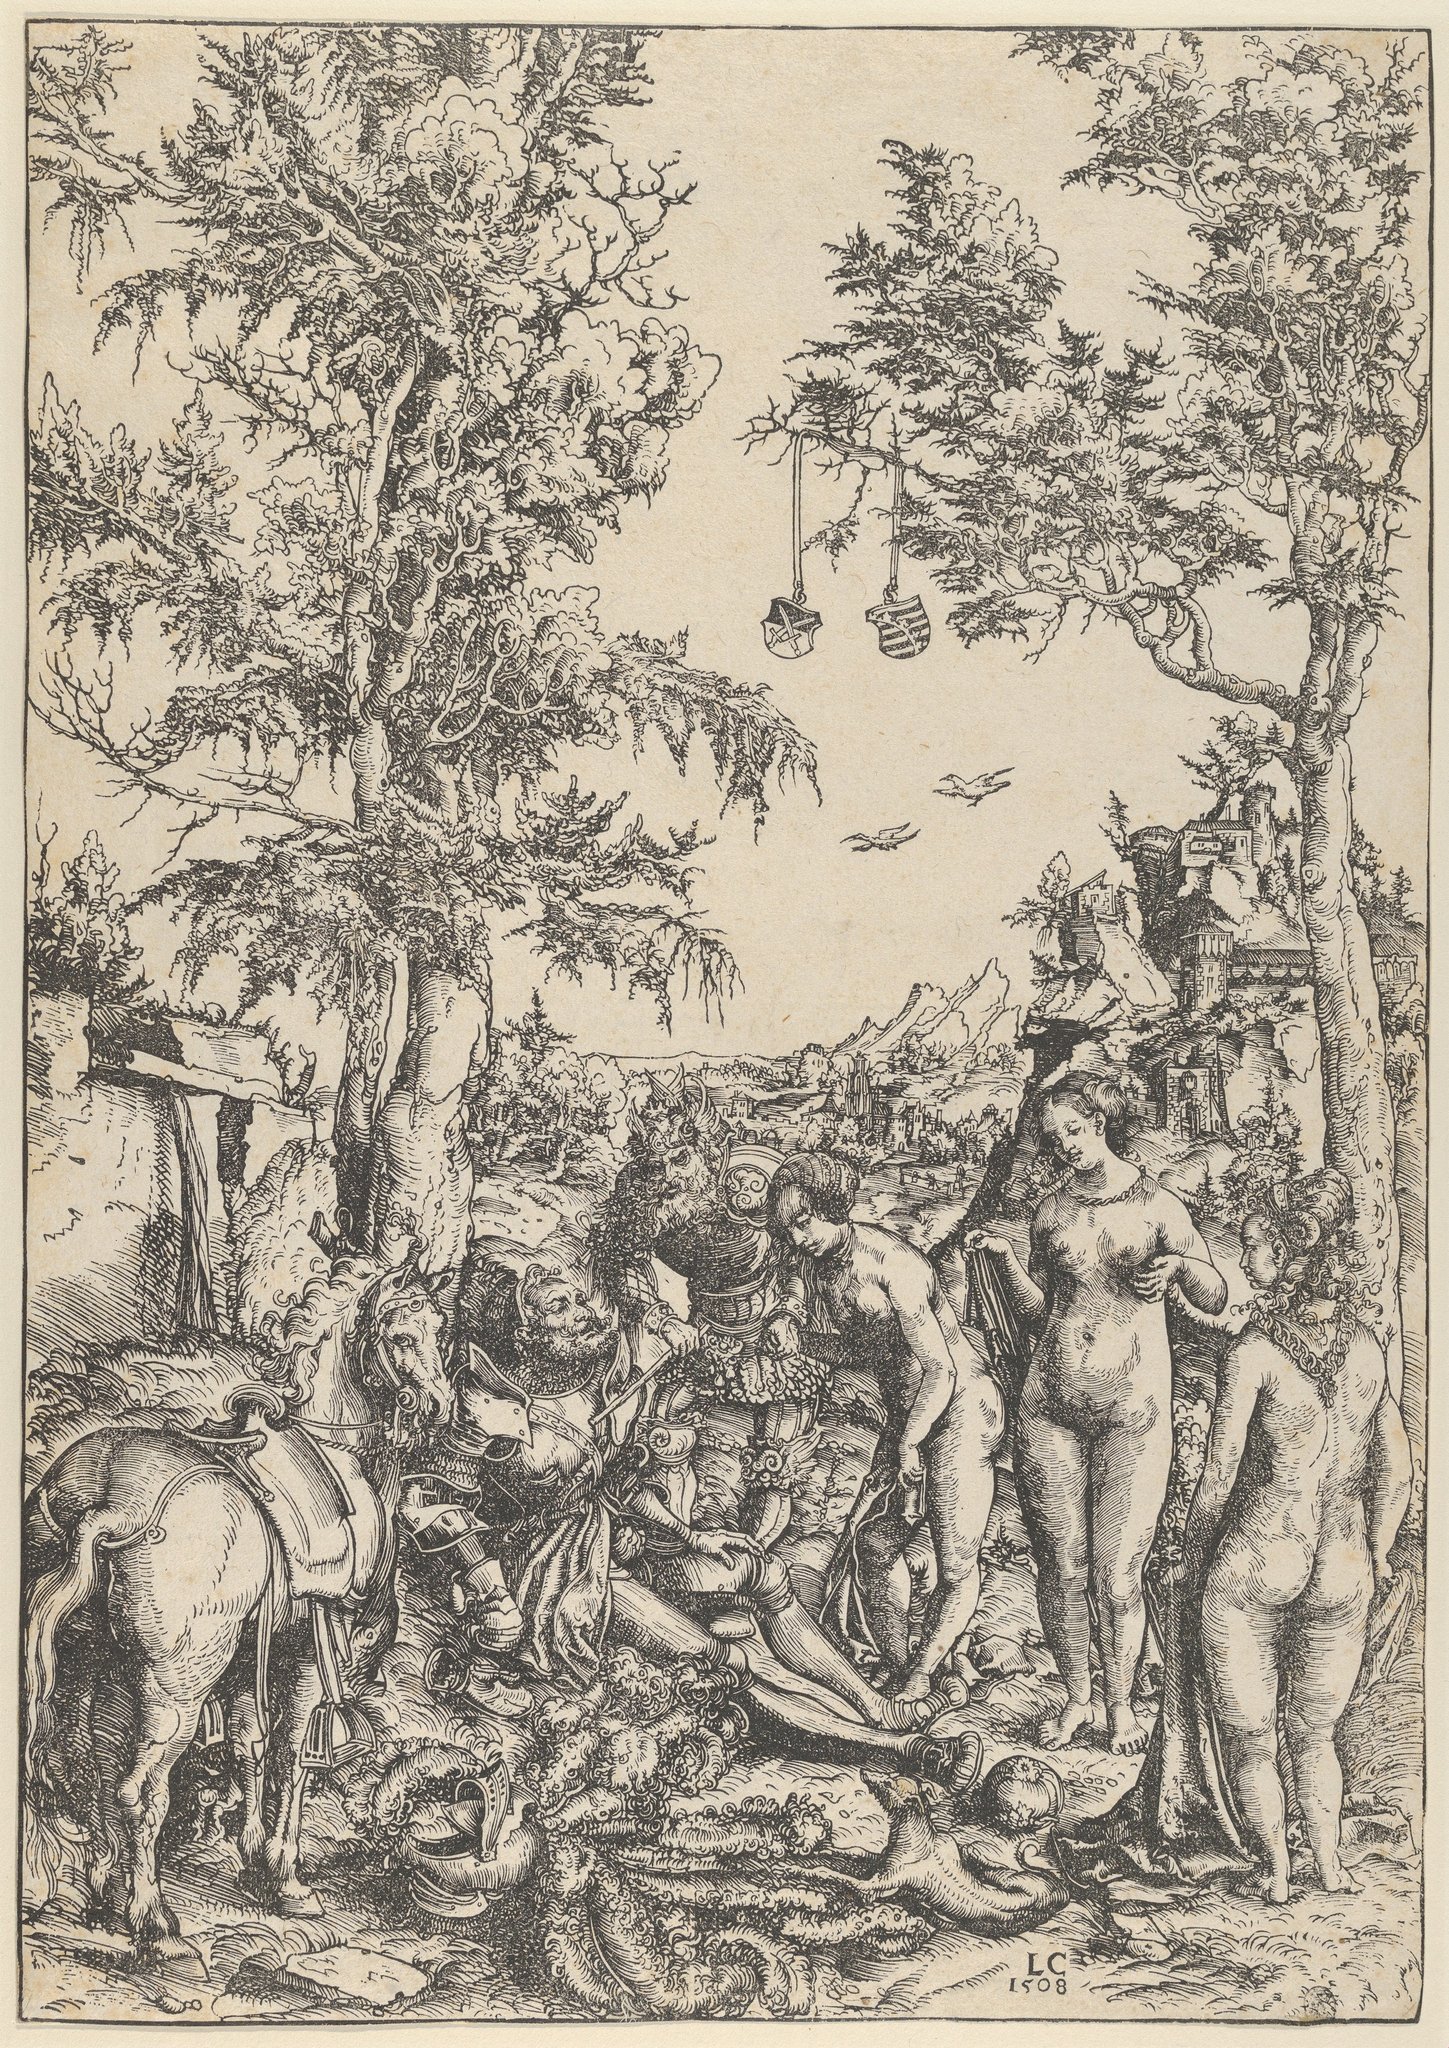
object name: print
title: The Judgment of Paris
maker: lucas cranach the elder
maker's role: artist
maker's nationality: german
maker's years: 1472-1553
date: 1508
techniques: woodcut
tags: soldiers,men,female nudes,horses,trees